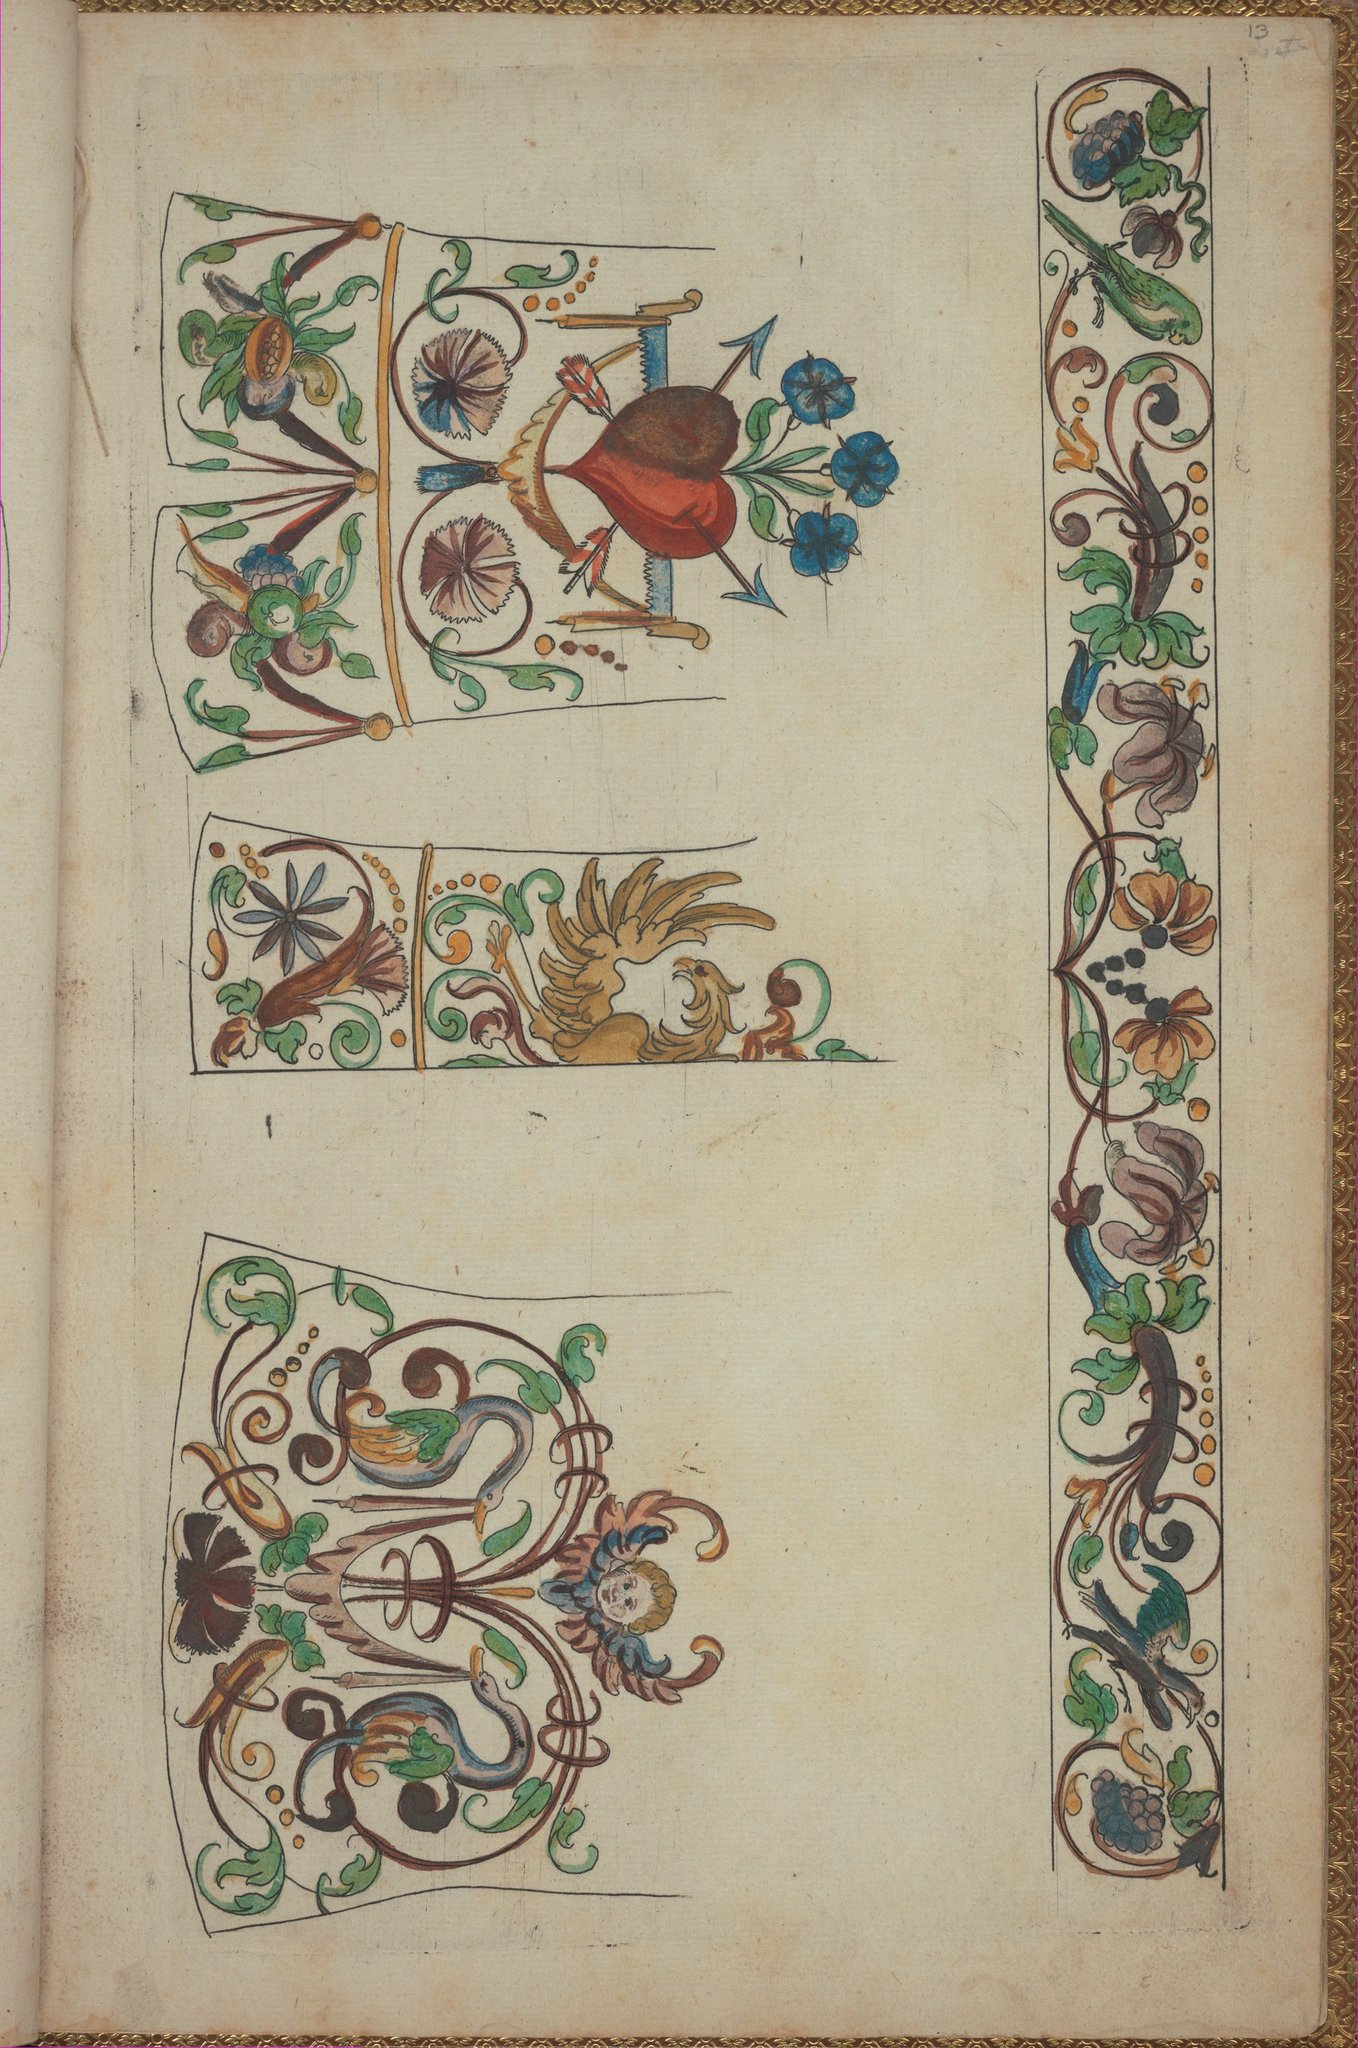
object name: book print ornament architecture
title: New Modelbüch (Page 13r)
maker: andreas bretschneider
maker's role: designer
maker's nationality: german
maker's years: 1573-1645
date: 1615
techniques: etching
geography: germany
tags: birds,parrots